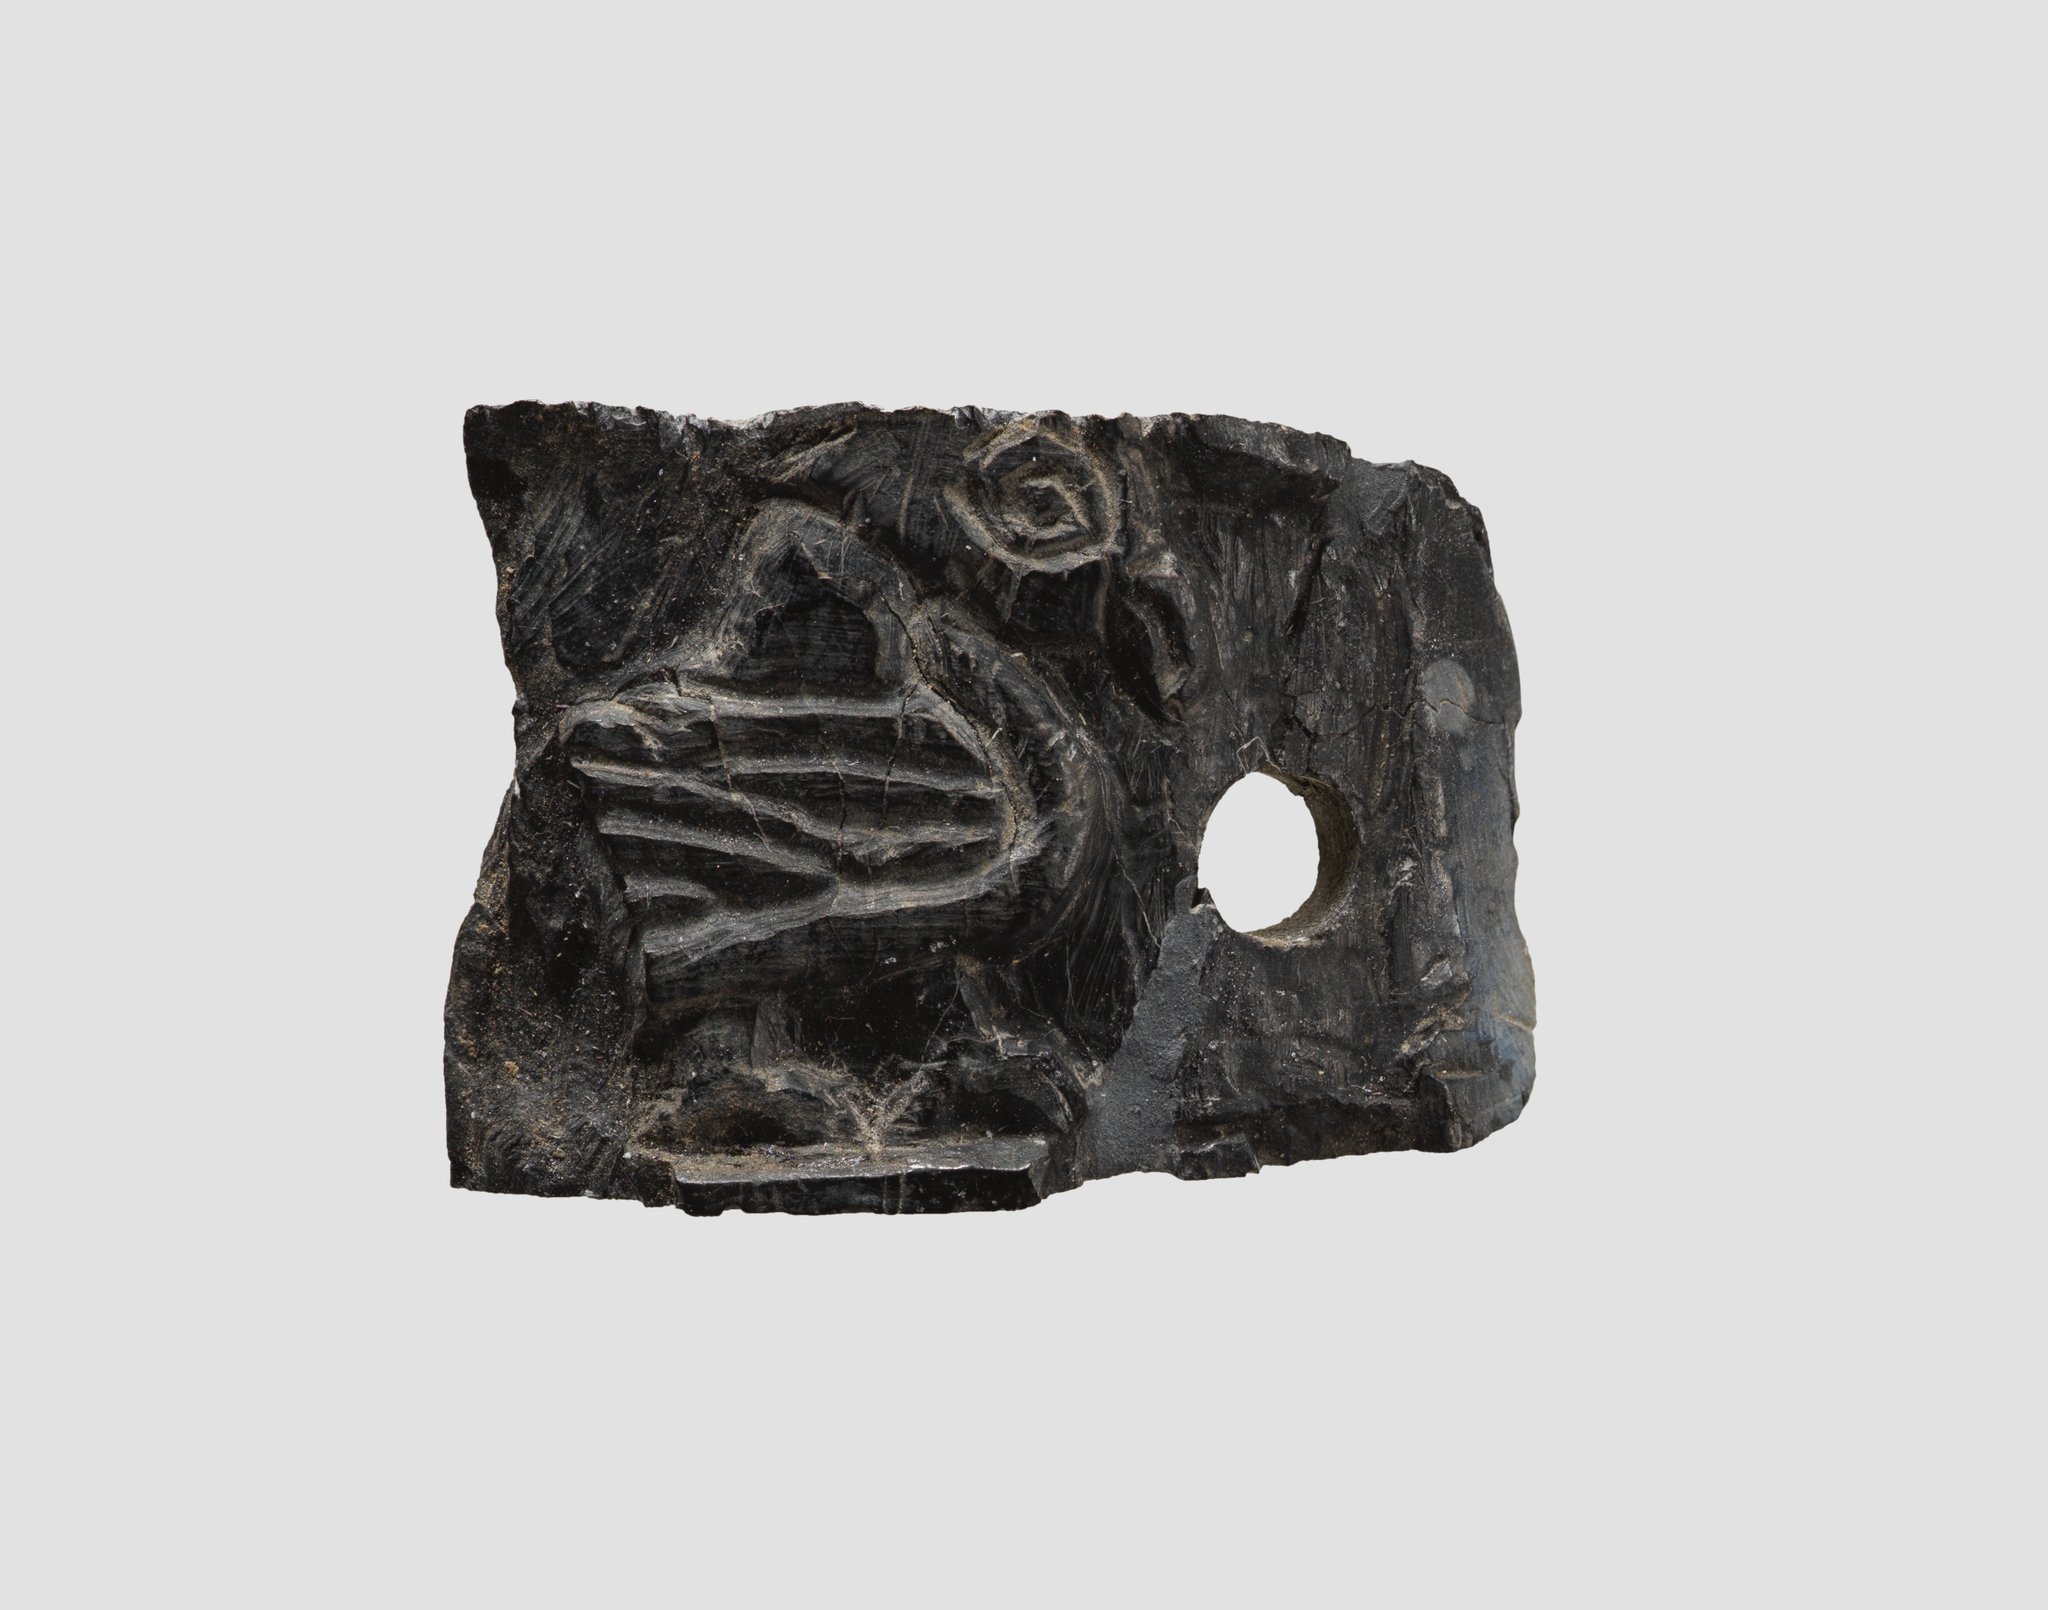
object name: relief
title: Plaque fragment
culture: iranian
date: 900-801 BCE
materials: ivory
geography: iran